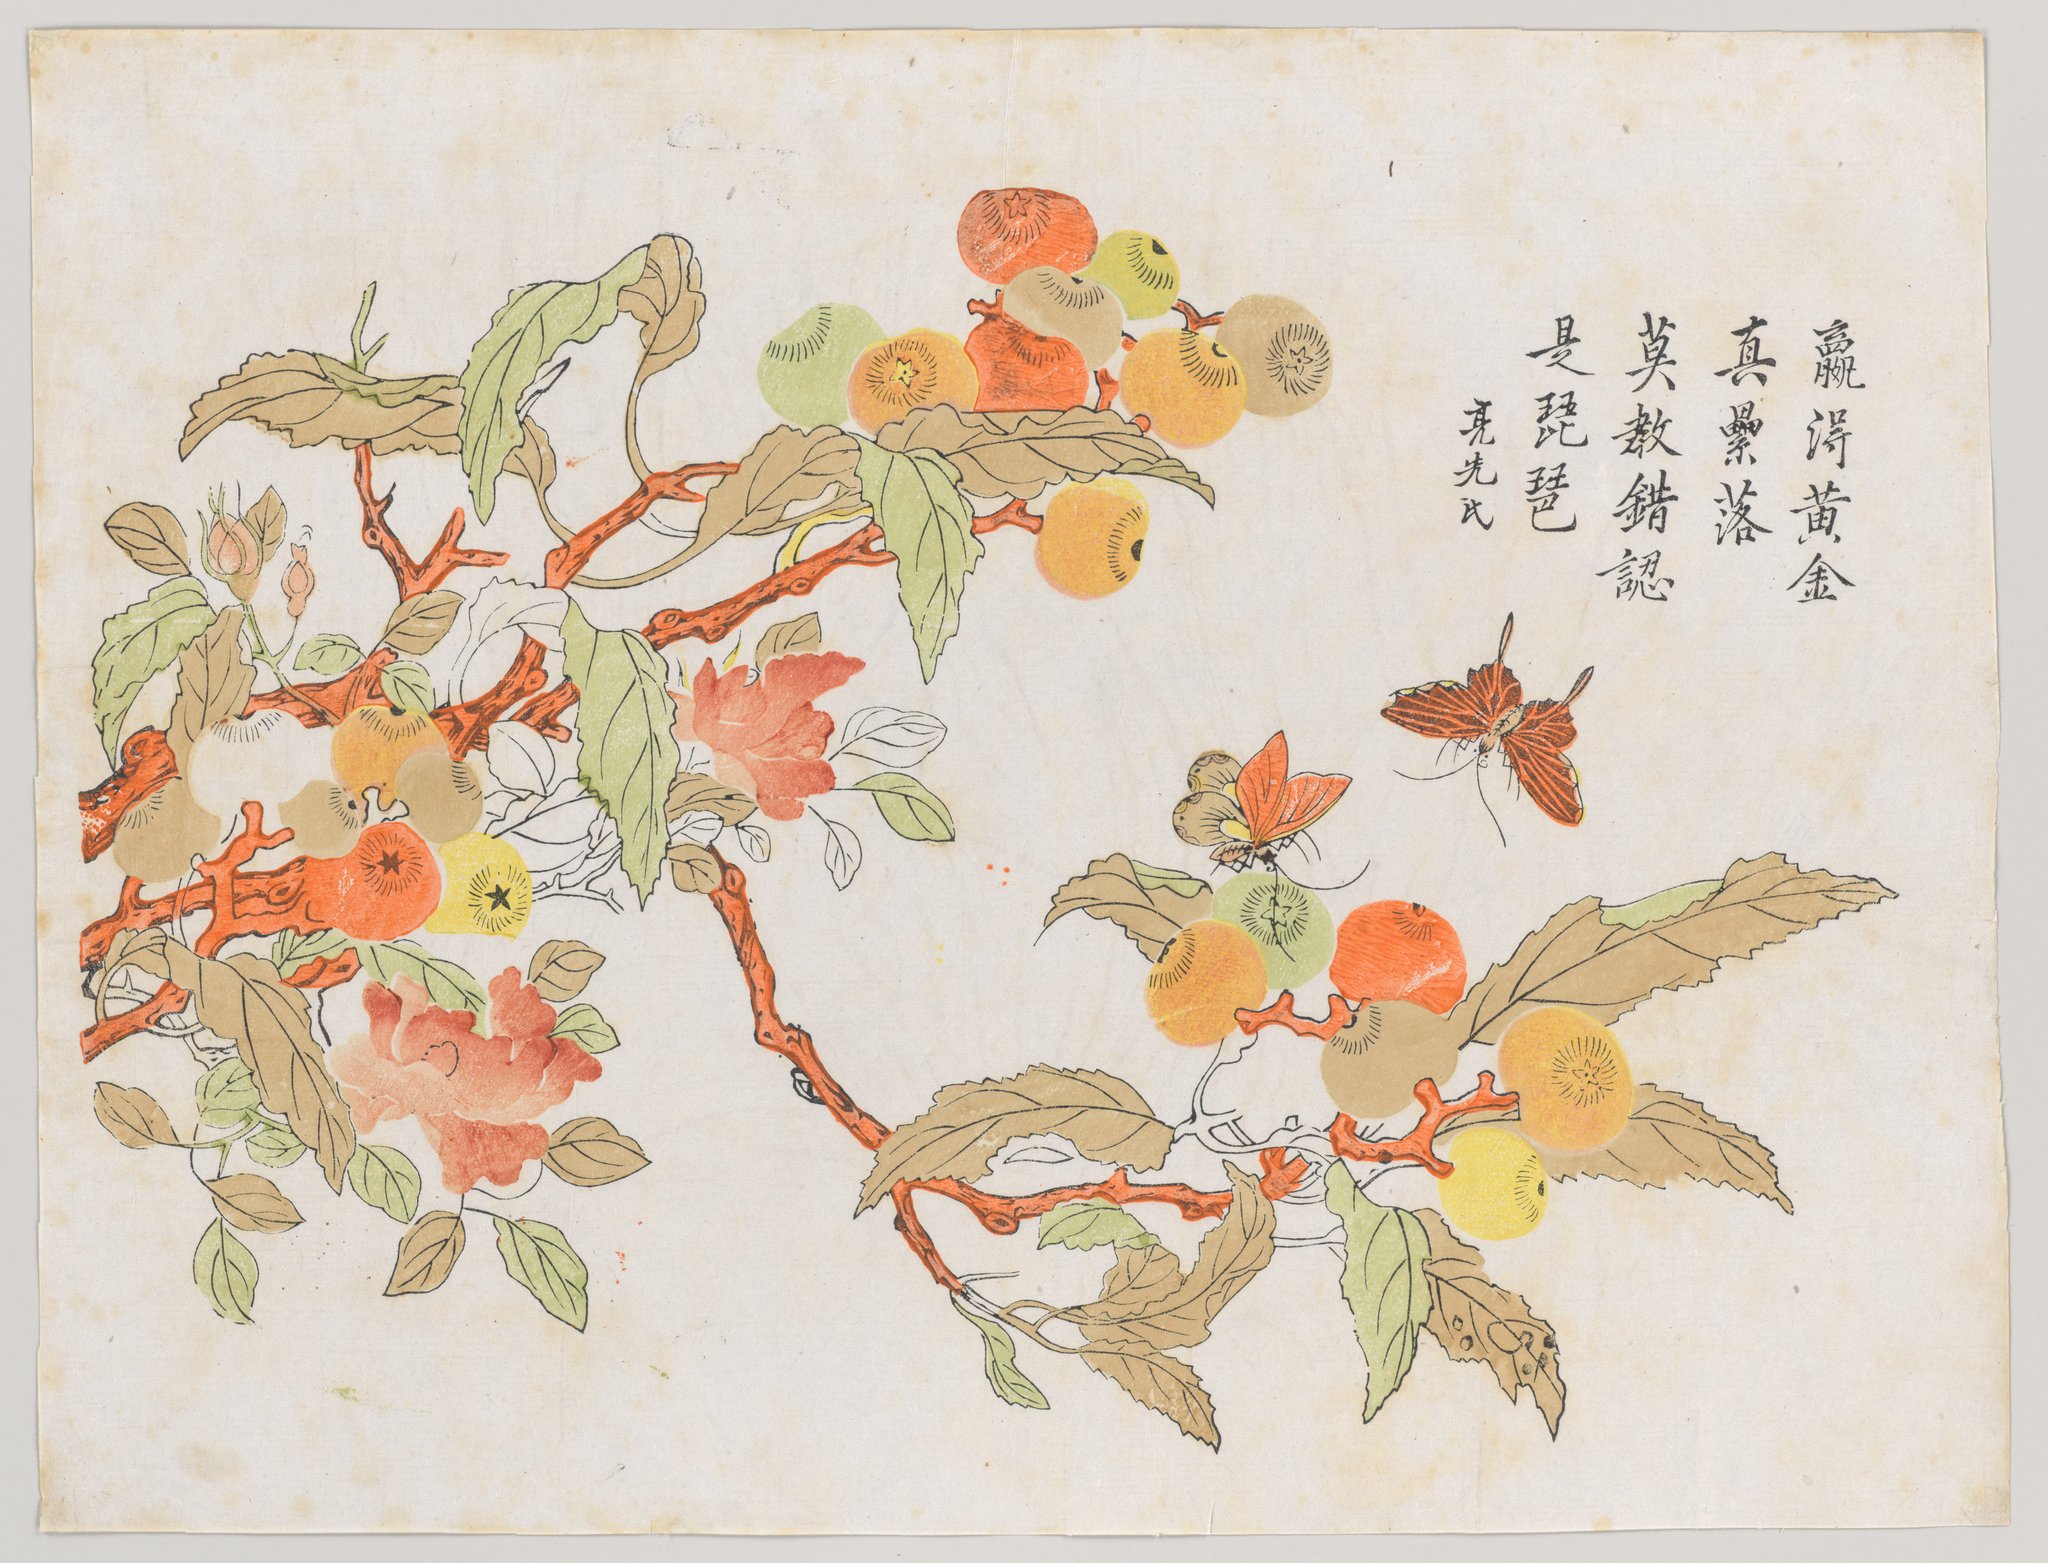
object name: print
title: Butterflies on Loquats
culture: chinese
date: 1701-1800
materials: ink, paper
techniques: polychrome, woodblock print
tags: fruit,butterflies